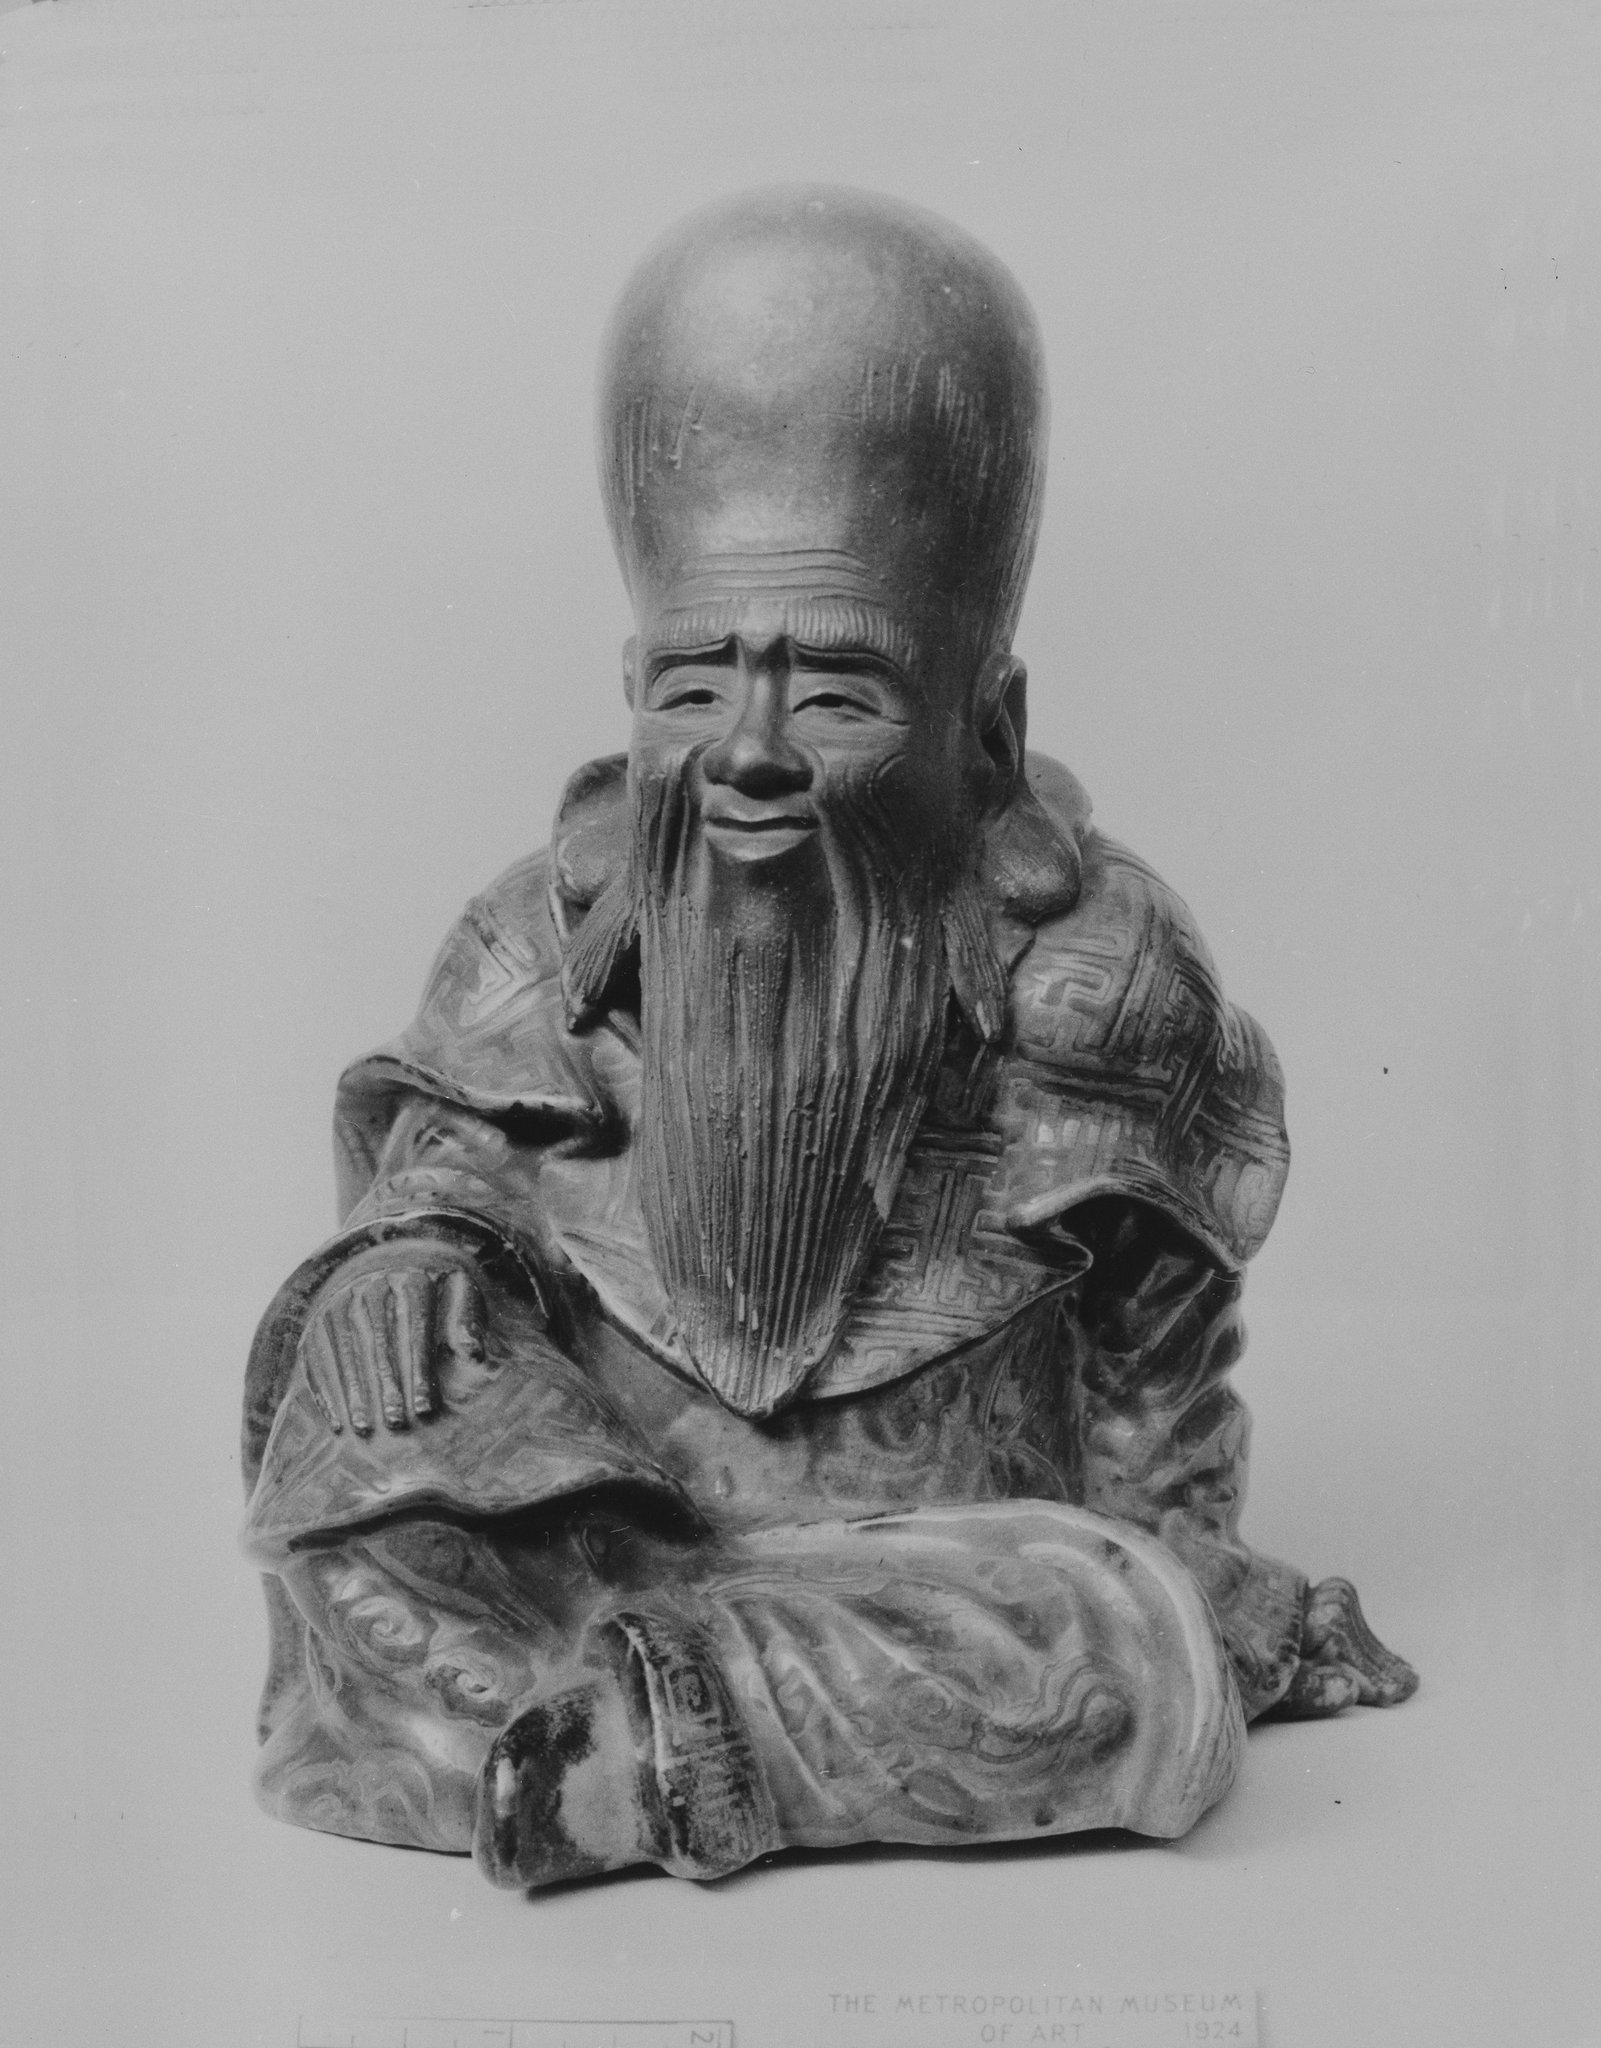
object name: alcove ornament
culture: japanese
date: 1750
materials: enamel, faience, glaze